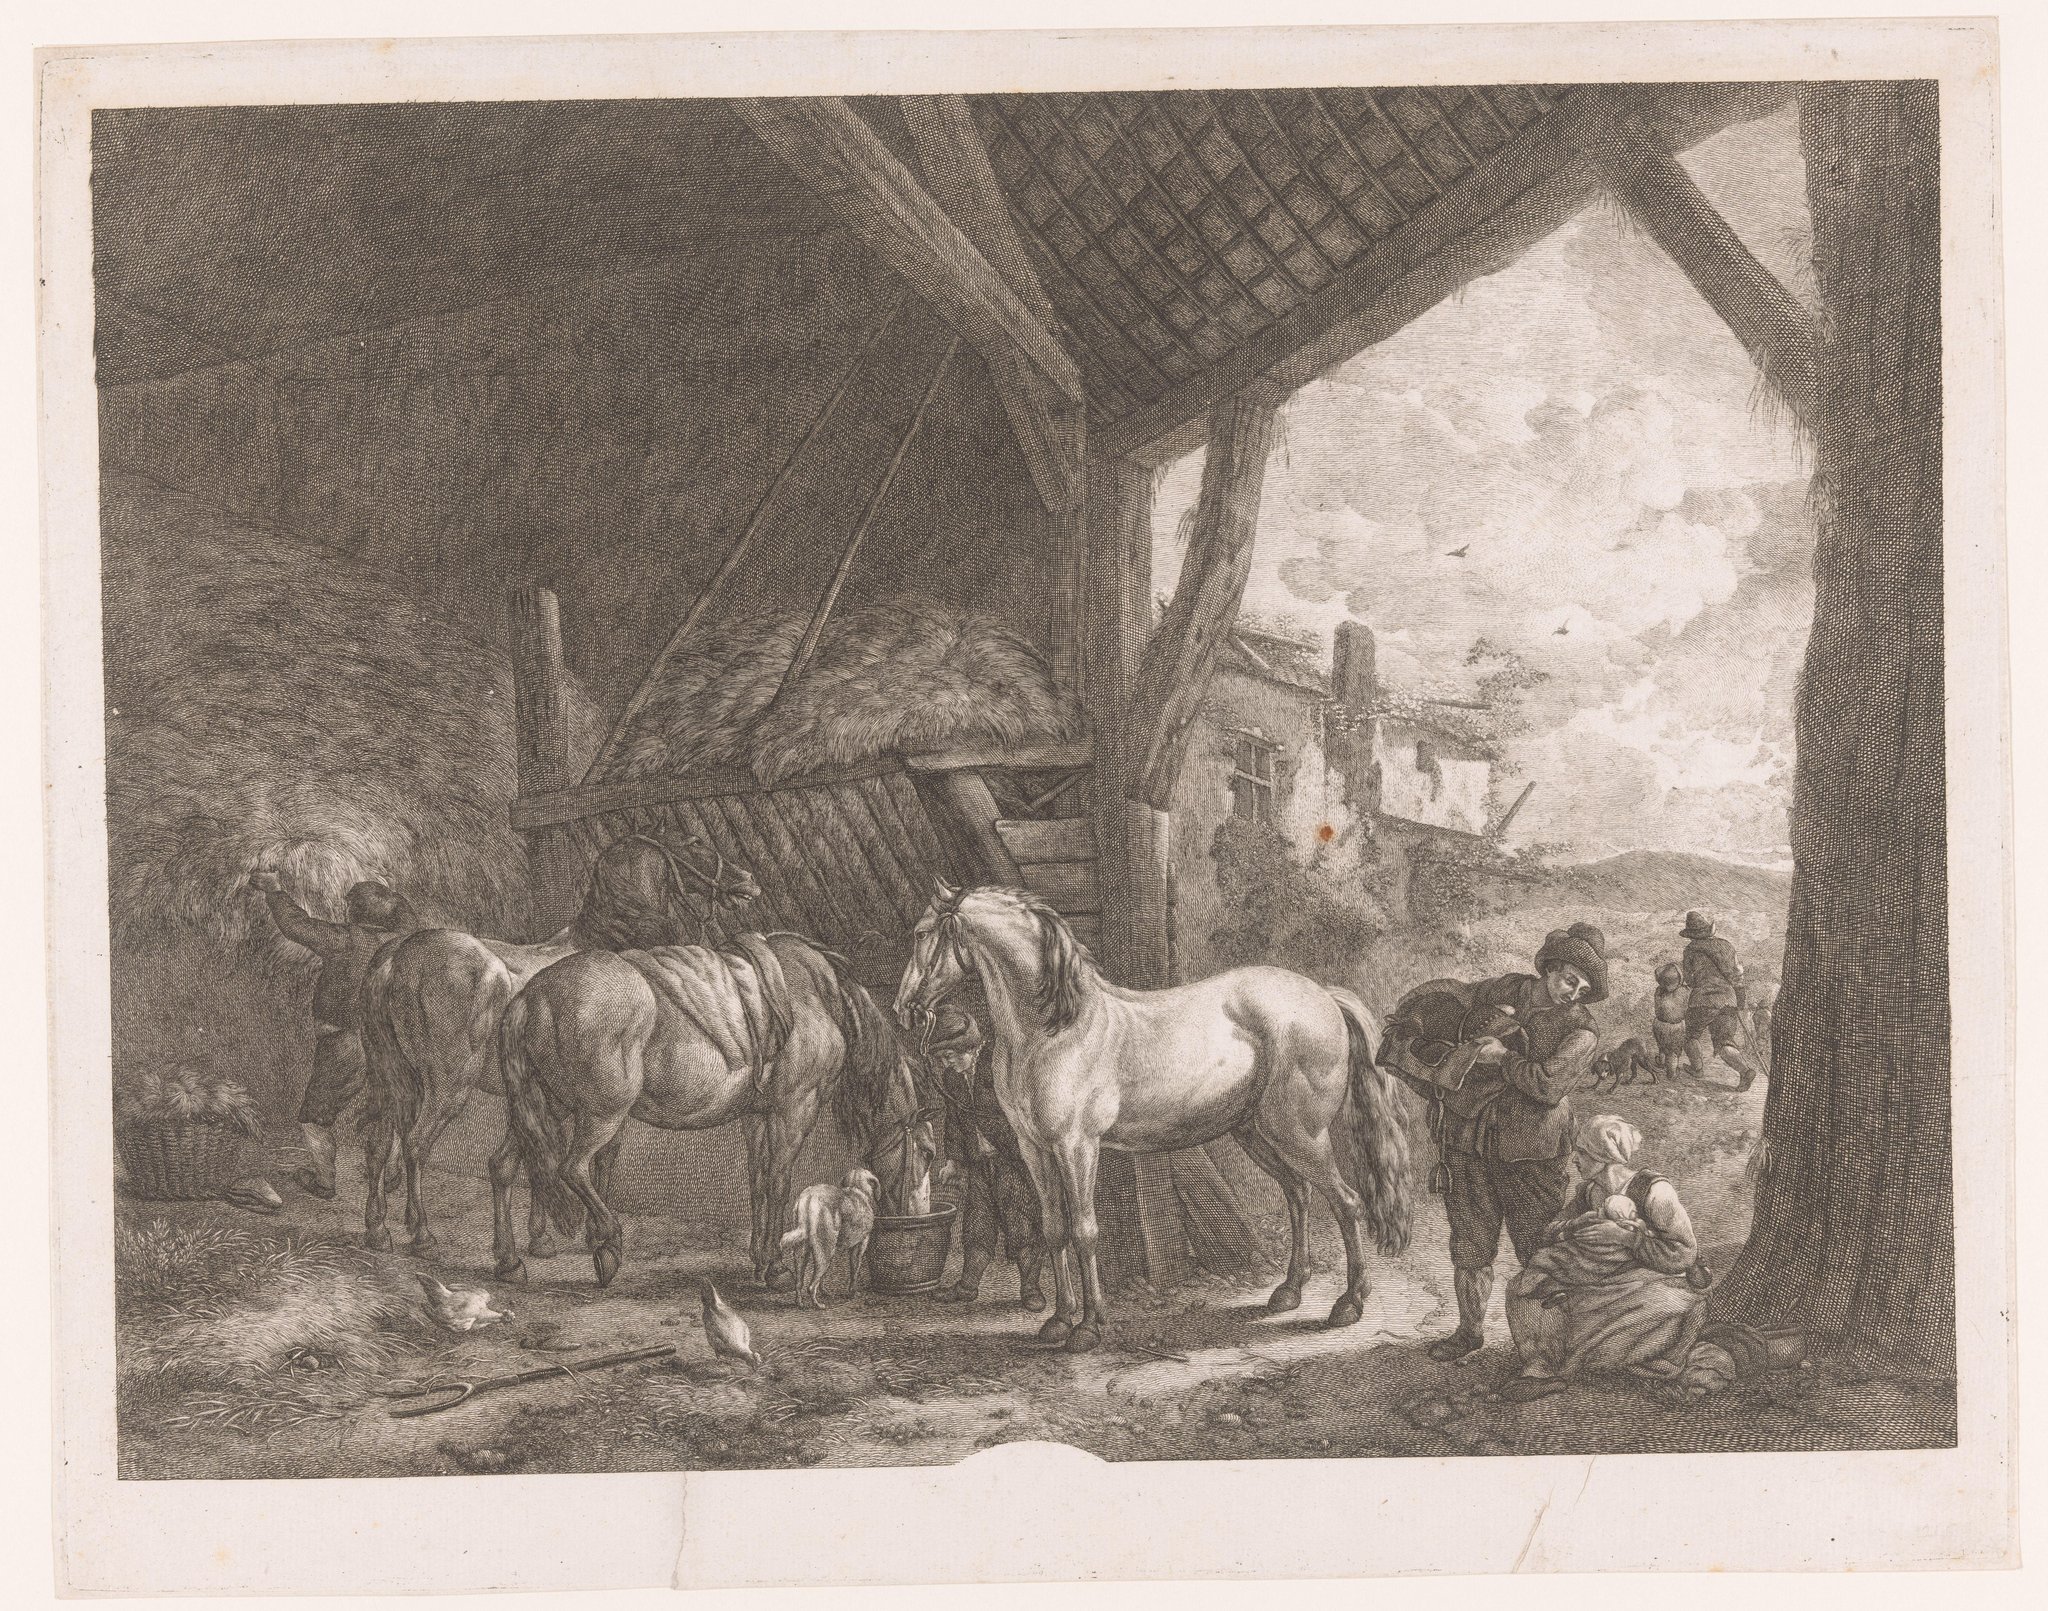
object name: print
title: Prenten naar schilderijen door Philips Wouwerman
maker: jean moyreau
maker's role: print maker, publisher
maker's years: 1690-1762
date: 1755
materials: paper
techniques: engraving, etching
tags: barn, horse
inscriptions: collector's mark: Lugt 240, inscription: ‘De Vlaamsche stal n: 79’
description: Maakt deel uit van een serie van 89 prenten te dateren tussen ca. 1733-1762, naar het geschilderde oeuvre van Philips Wouwerman. Dit betreft plaat 79.